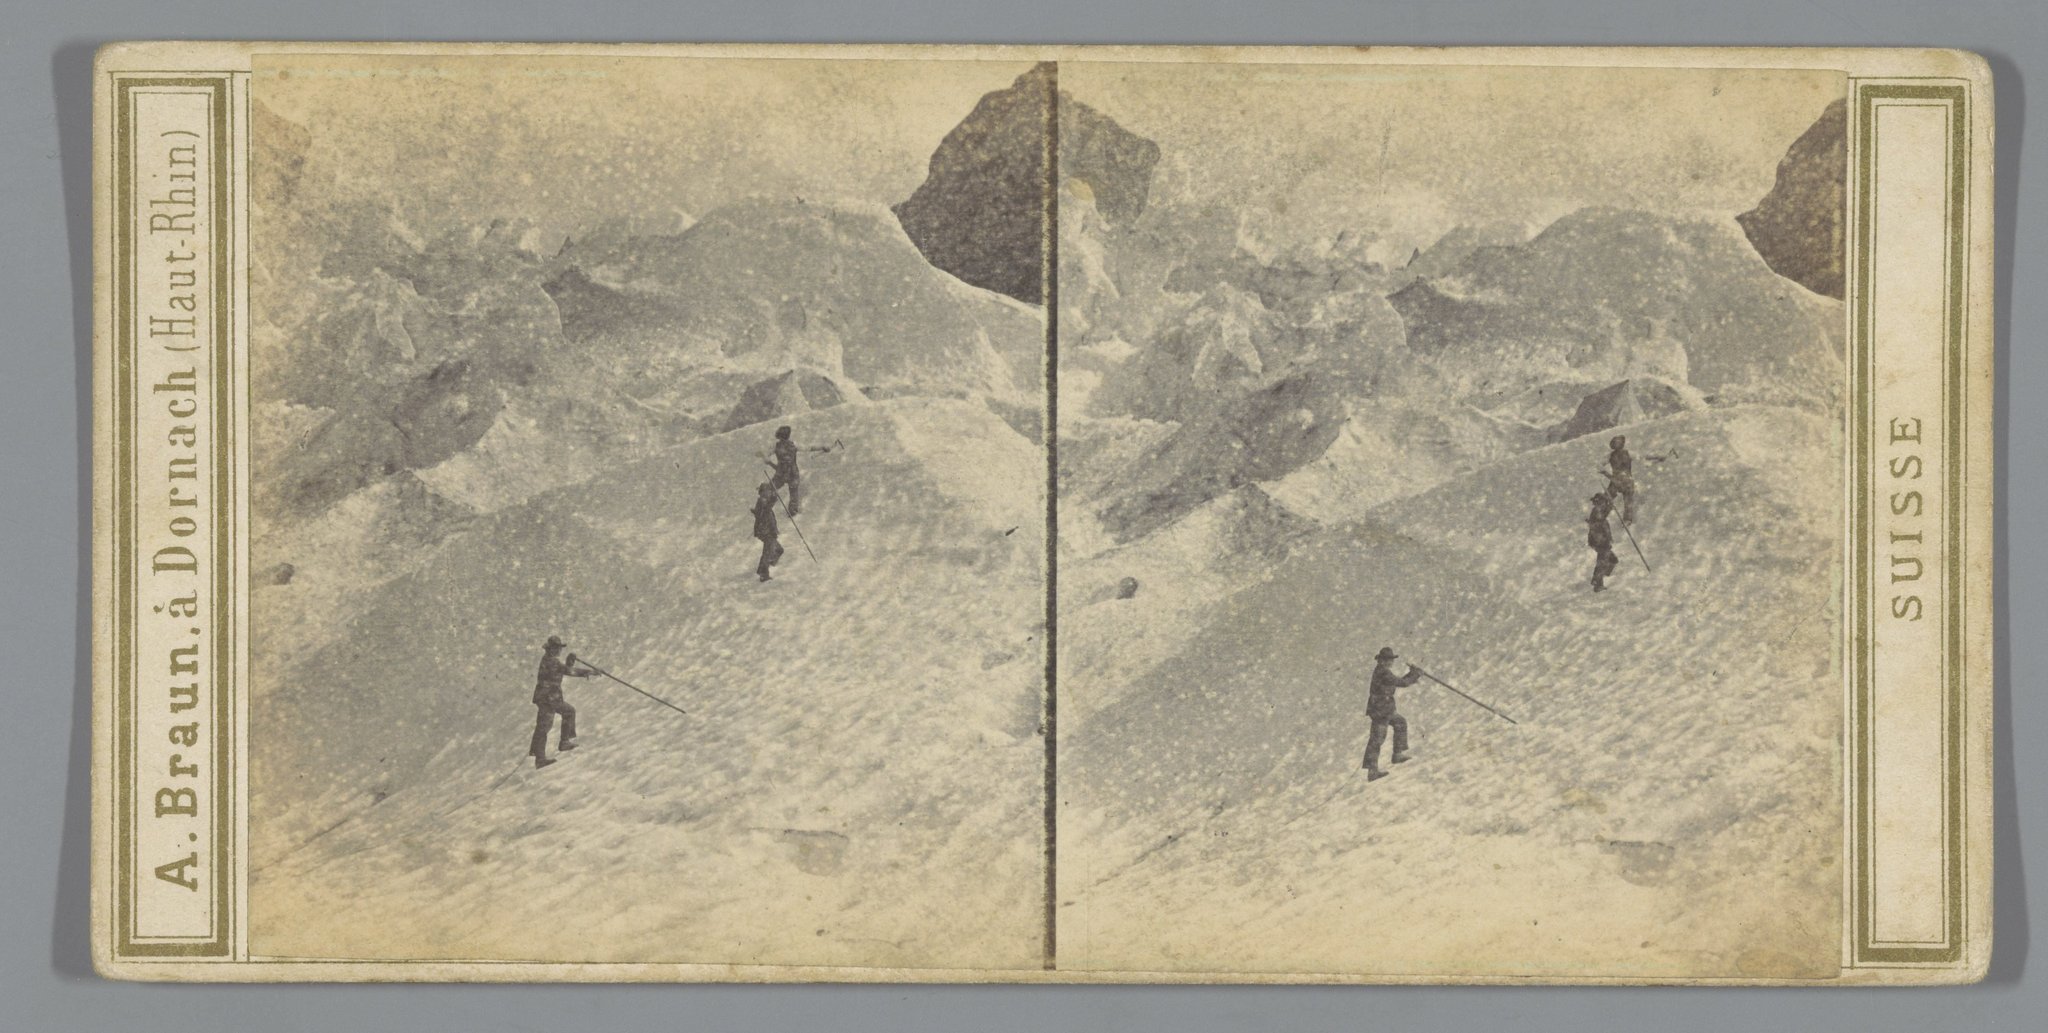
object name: stereograph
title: Détail de glace au Glacier supérieur de Grindelwald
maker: Anonymous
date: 1860-1866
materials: cardboard, paper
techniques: albumen print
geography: berner alpen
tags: mountain climbing, mountaineering, glacier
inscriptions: number: ‘No 3288.’